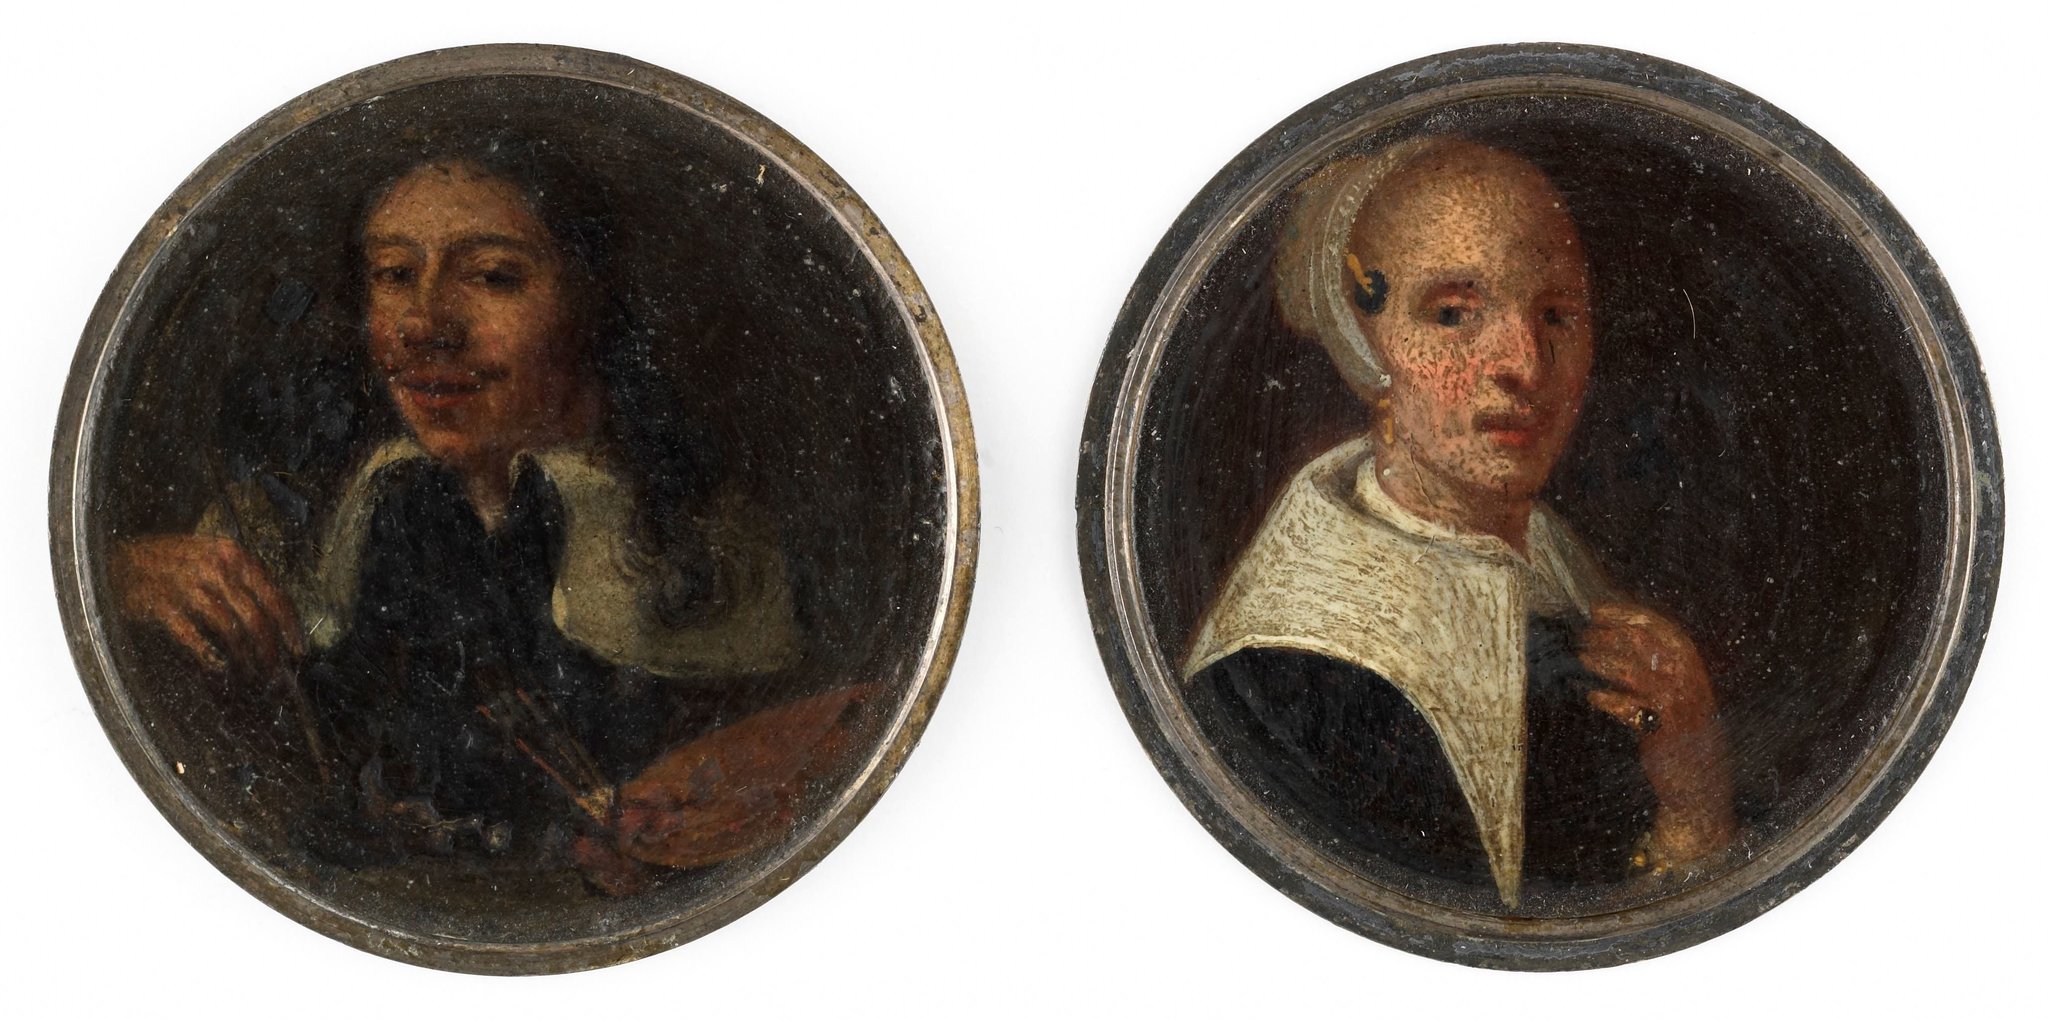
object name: painting, miniature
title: Portret van de vrouw van Johann Philip Lembke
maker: johann philipp lemke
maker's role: painter, print maker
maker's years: 1631-1711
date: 1650-1713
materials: oil, silver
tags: portrait, self-portrait of artist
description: Portret van de vrouw van Johann Philip Lembke (1631-1713). In buste, naar rechts. Geschilderd op de binnenzijden van een zilveren schroefdaalder uit 1632. Onderdeel van de collectie portretminiaturen.